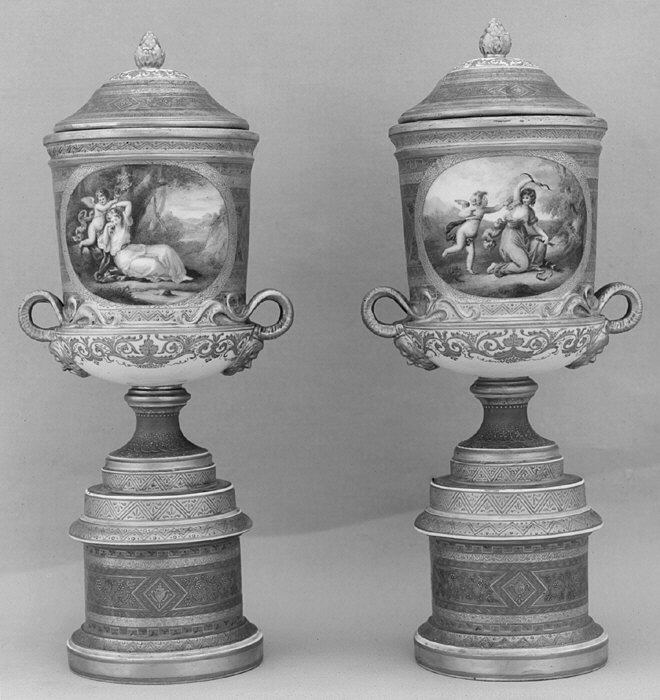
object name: vase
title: Pair of vases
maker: imperial porcelain manufactory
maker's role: manufactory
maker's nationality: austrian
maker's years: 1744-1864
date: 1780-1800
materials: hard paste porcelain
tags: women,cupid